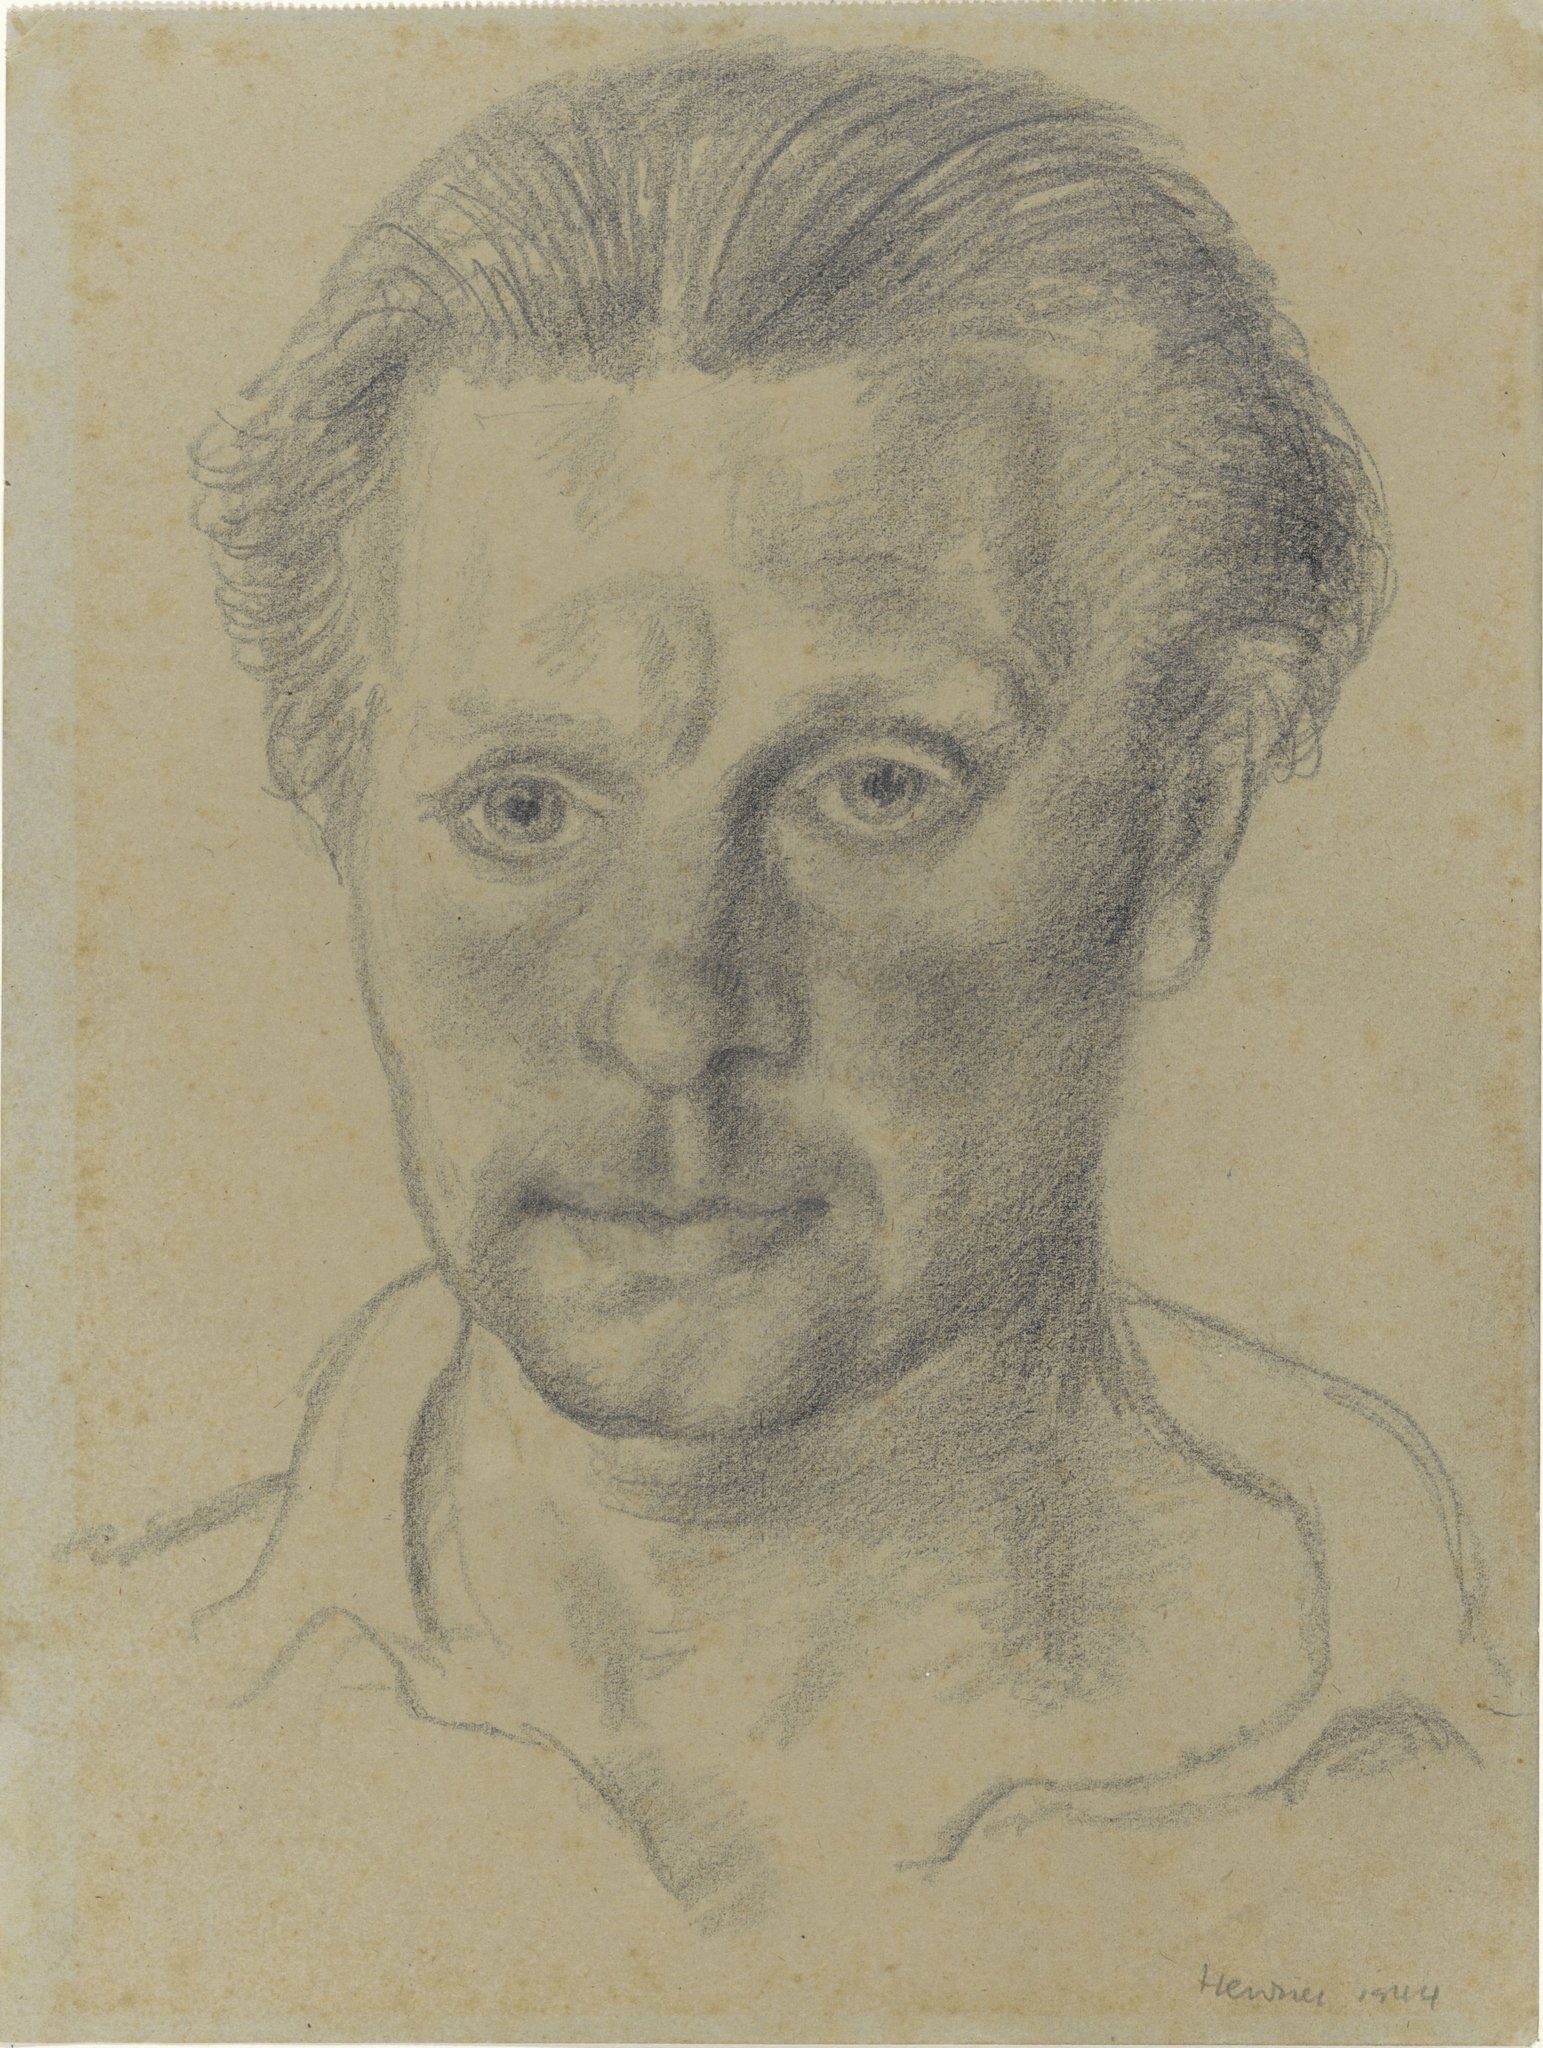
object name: drawing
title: Portret van een onbekende man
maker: henk henriët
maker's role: draughtsman, print maker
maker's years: 1903-1945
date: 1944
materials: paper, pencil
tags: anonymous historical person portrayed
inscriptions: collector's mark: Lugt 2228